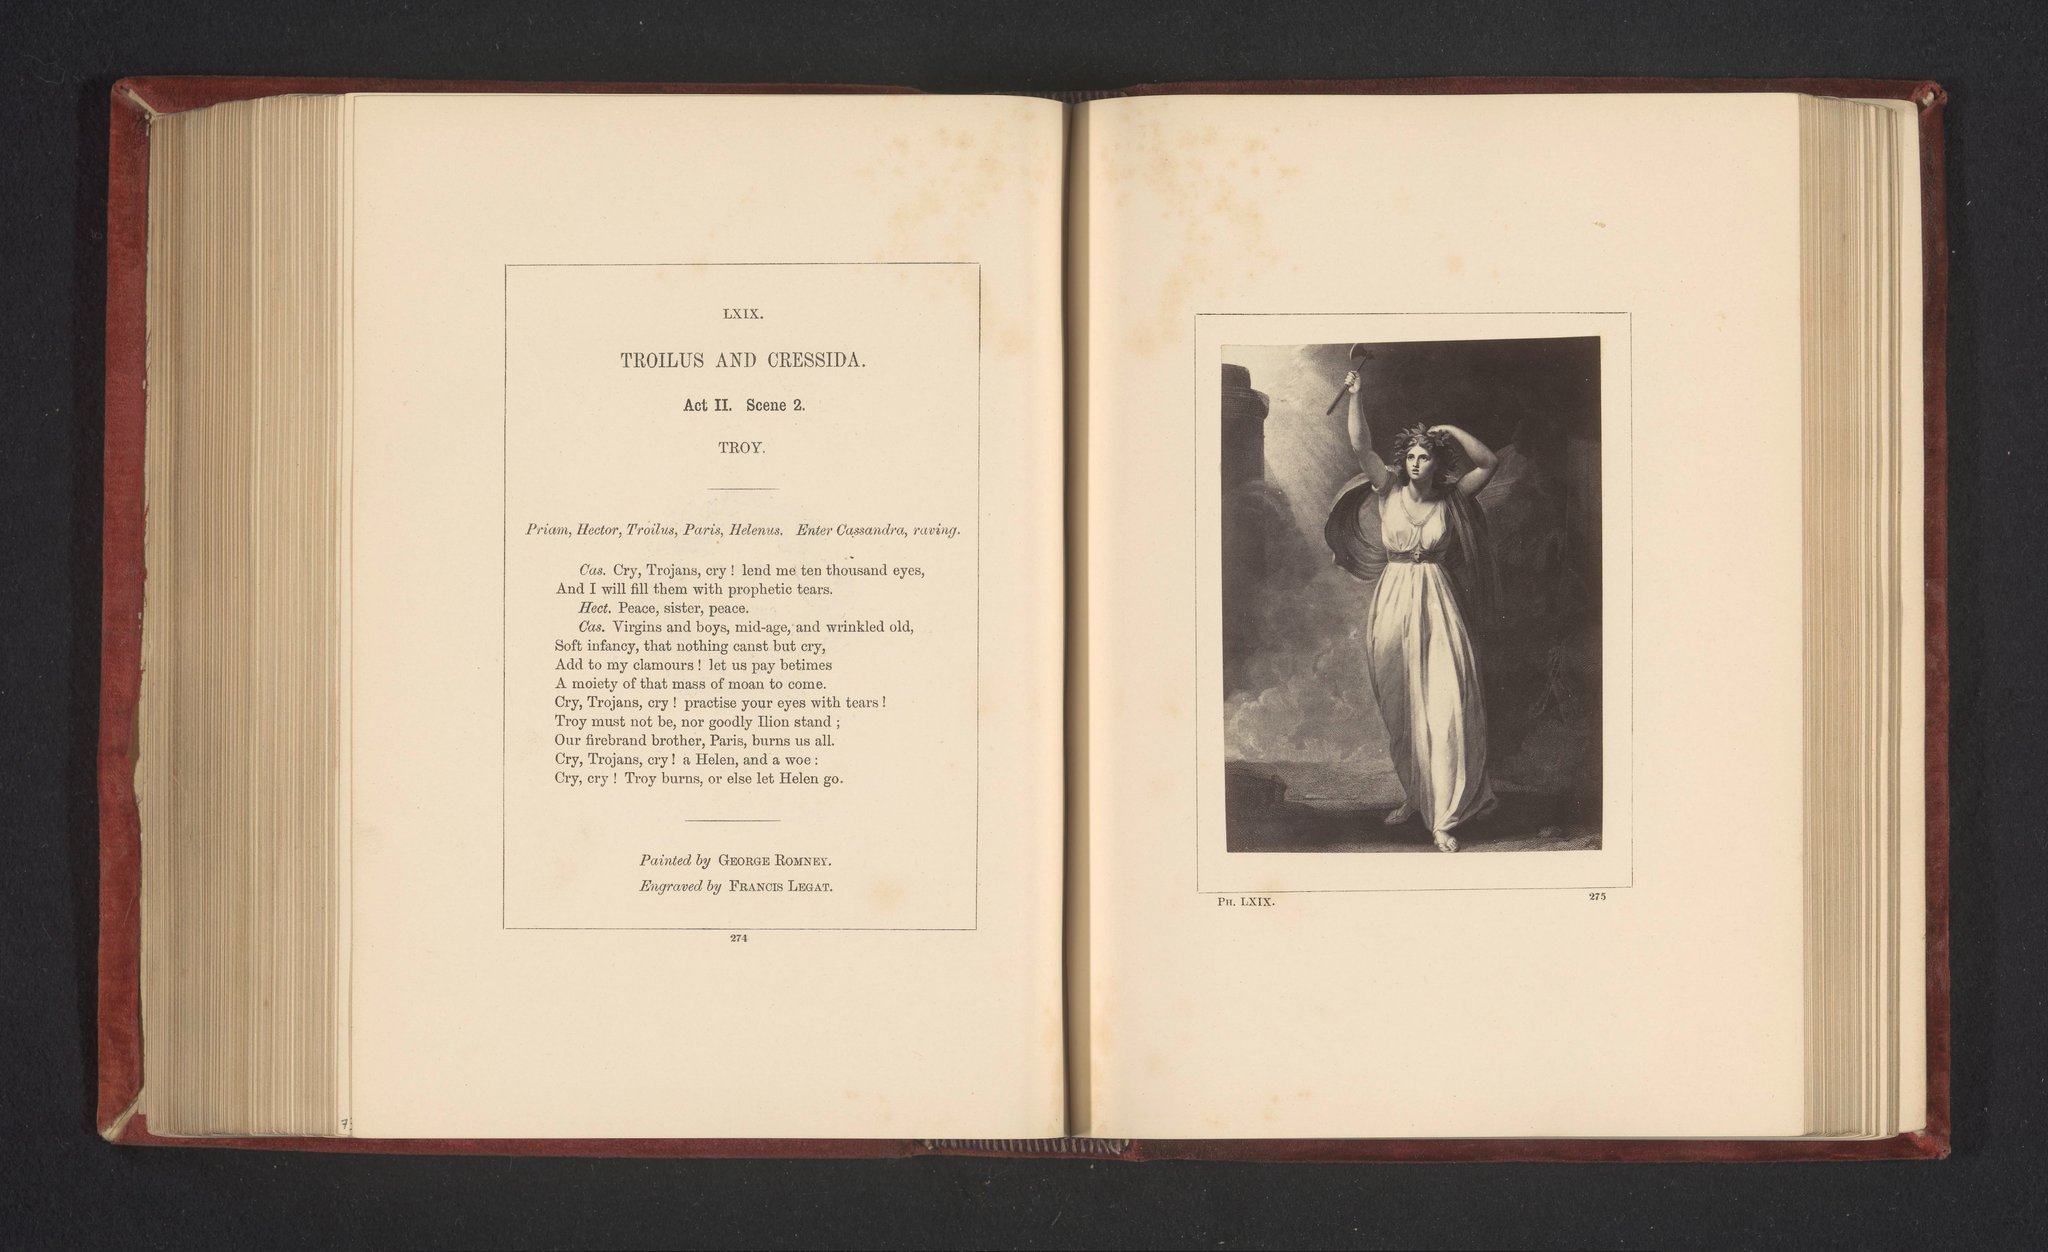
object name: photograph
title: Fotoreproductie van een prent naar een schilderij door George Romney, voorstellend een scene uit Troilus en Cressida door William Shakespeare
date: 1854-1864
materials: photographic support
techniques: albumen print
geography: london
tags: specific works of literature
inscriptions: number: ‘Ph. LXIX. 275’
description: Te zien is akte II, scene 2 met Cassandra die ijlend verschijnt.